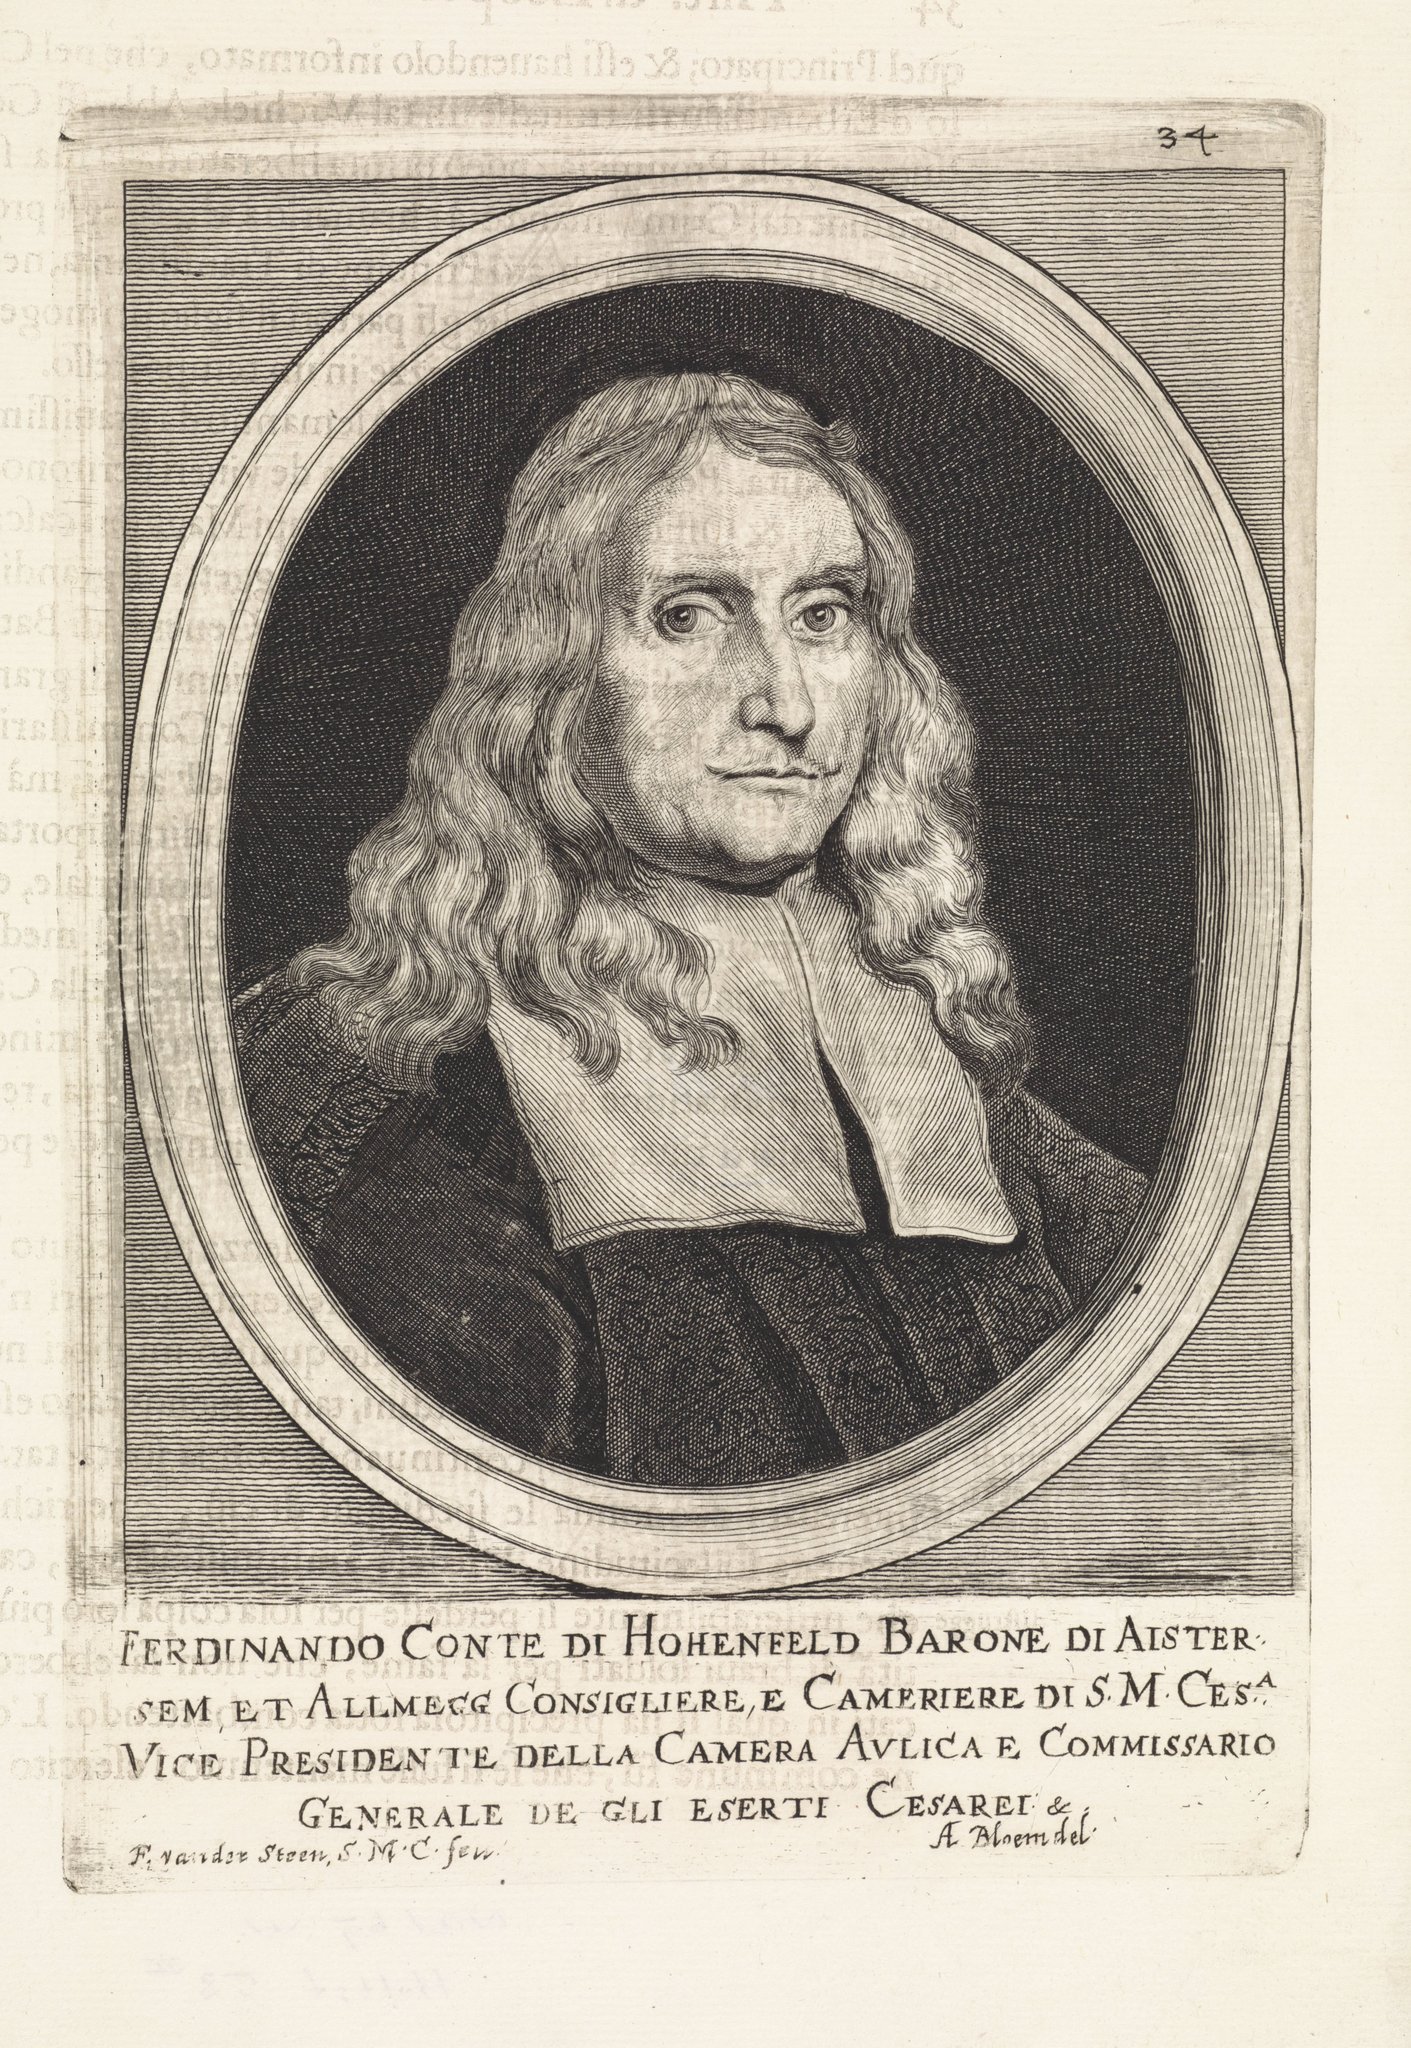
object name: print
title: Portret van Ferdinand graaf van Hohenfeld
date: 1670-1674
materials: paper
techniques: engraving, etching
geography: vienna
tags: ferdinand graaf van hohenfeld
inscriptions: collector's mark: Lugt 2228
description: Portret van Ferdinand, graaf van Hohenfeld, vrijheer van Aistersheim en Allmeg. Onderaan in de marge een vierregelige tekst in het Italiaans. Rechtsboven genummerd: 34